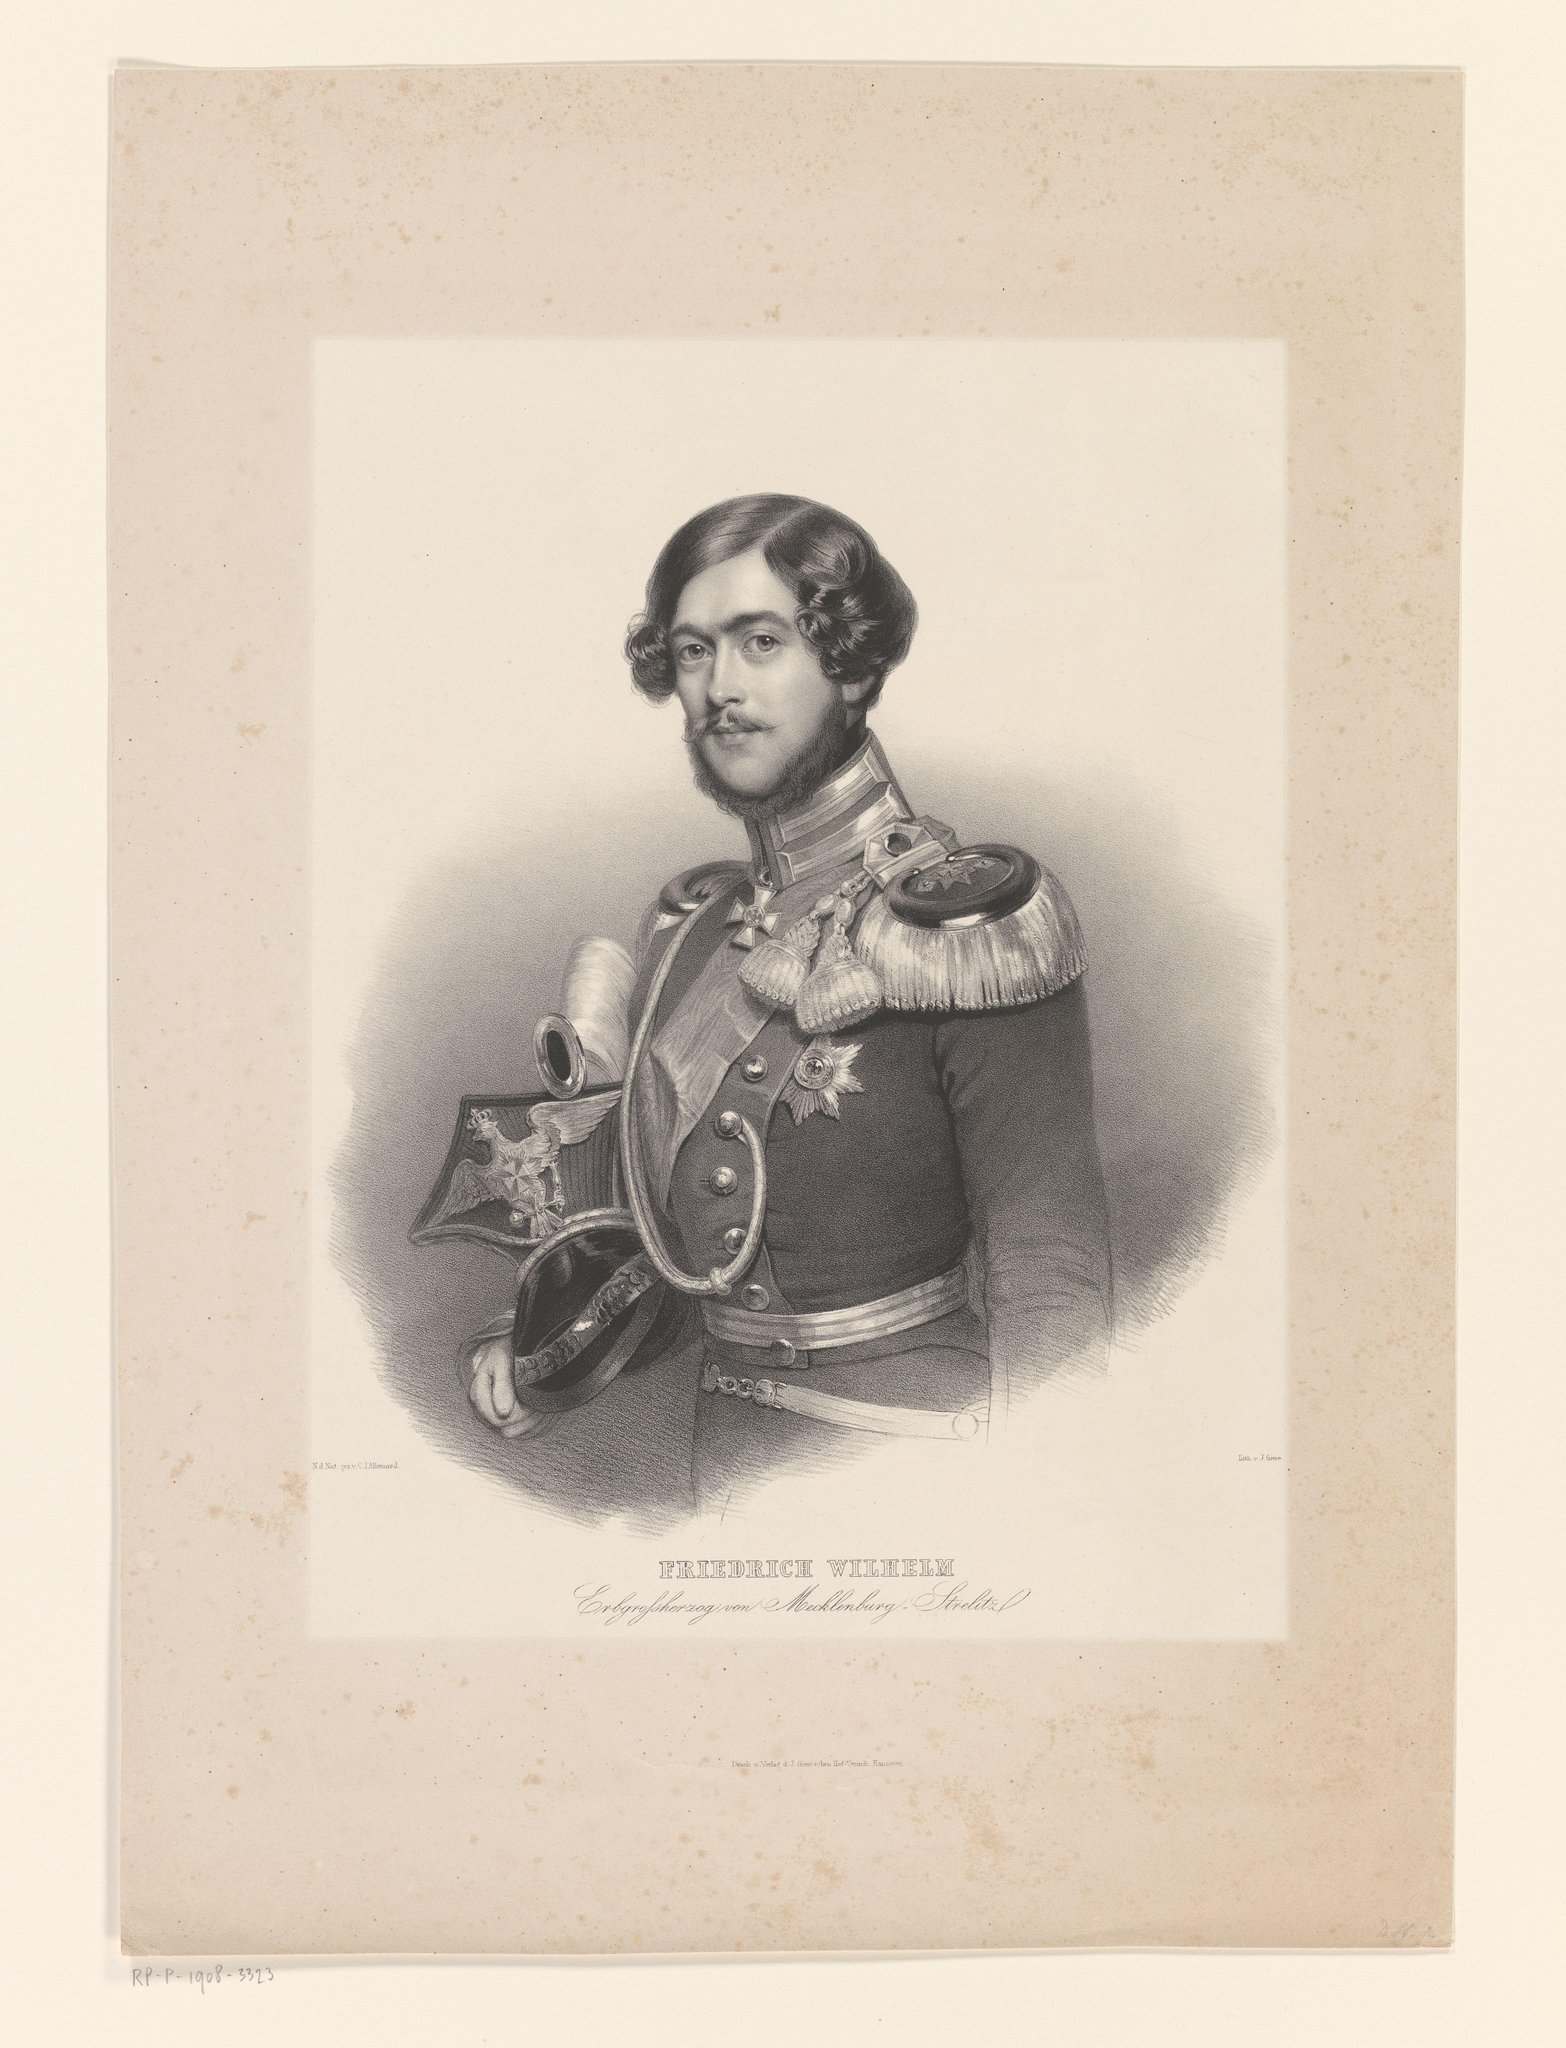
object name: print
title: Friedrich Wilhelm, Erbgrossherzog von Mecklenburg-Strelitz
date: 1817-1880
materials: paper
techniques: lithograph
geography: hannover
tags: adult man, historical persons, beard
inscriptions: collector's mark: Lugt 2228